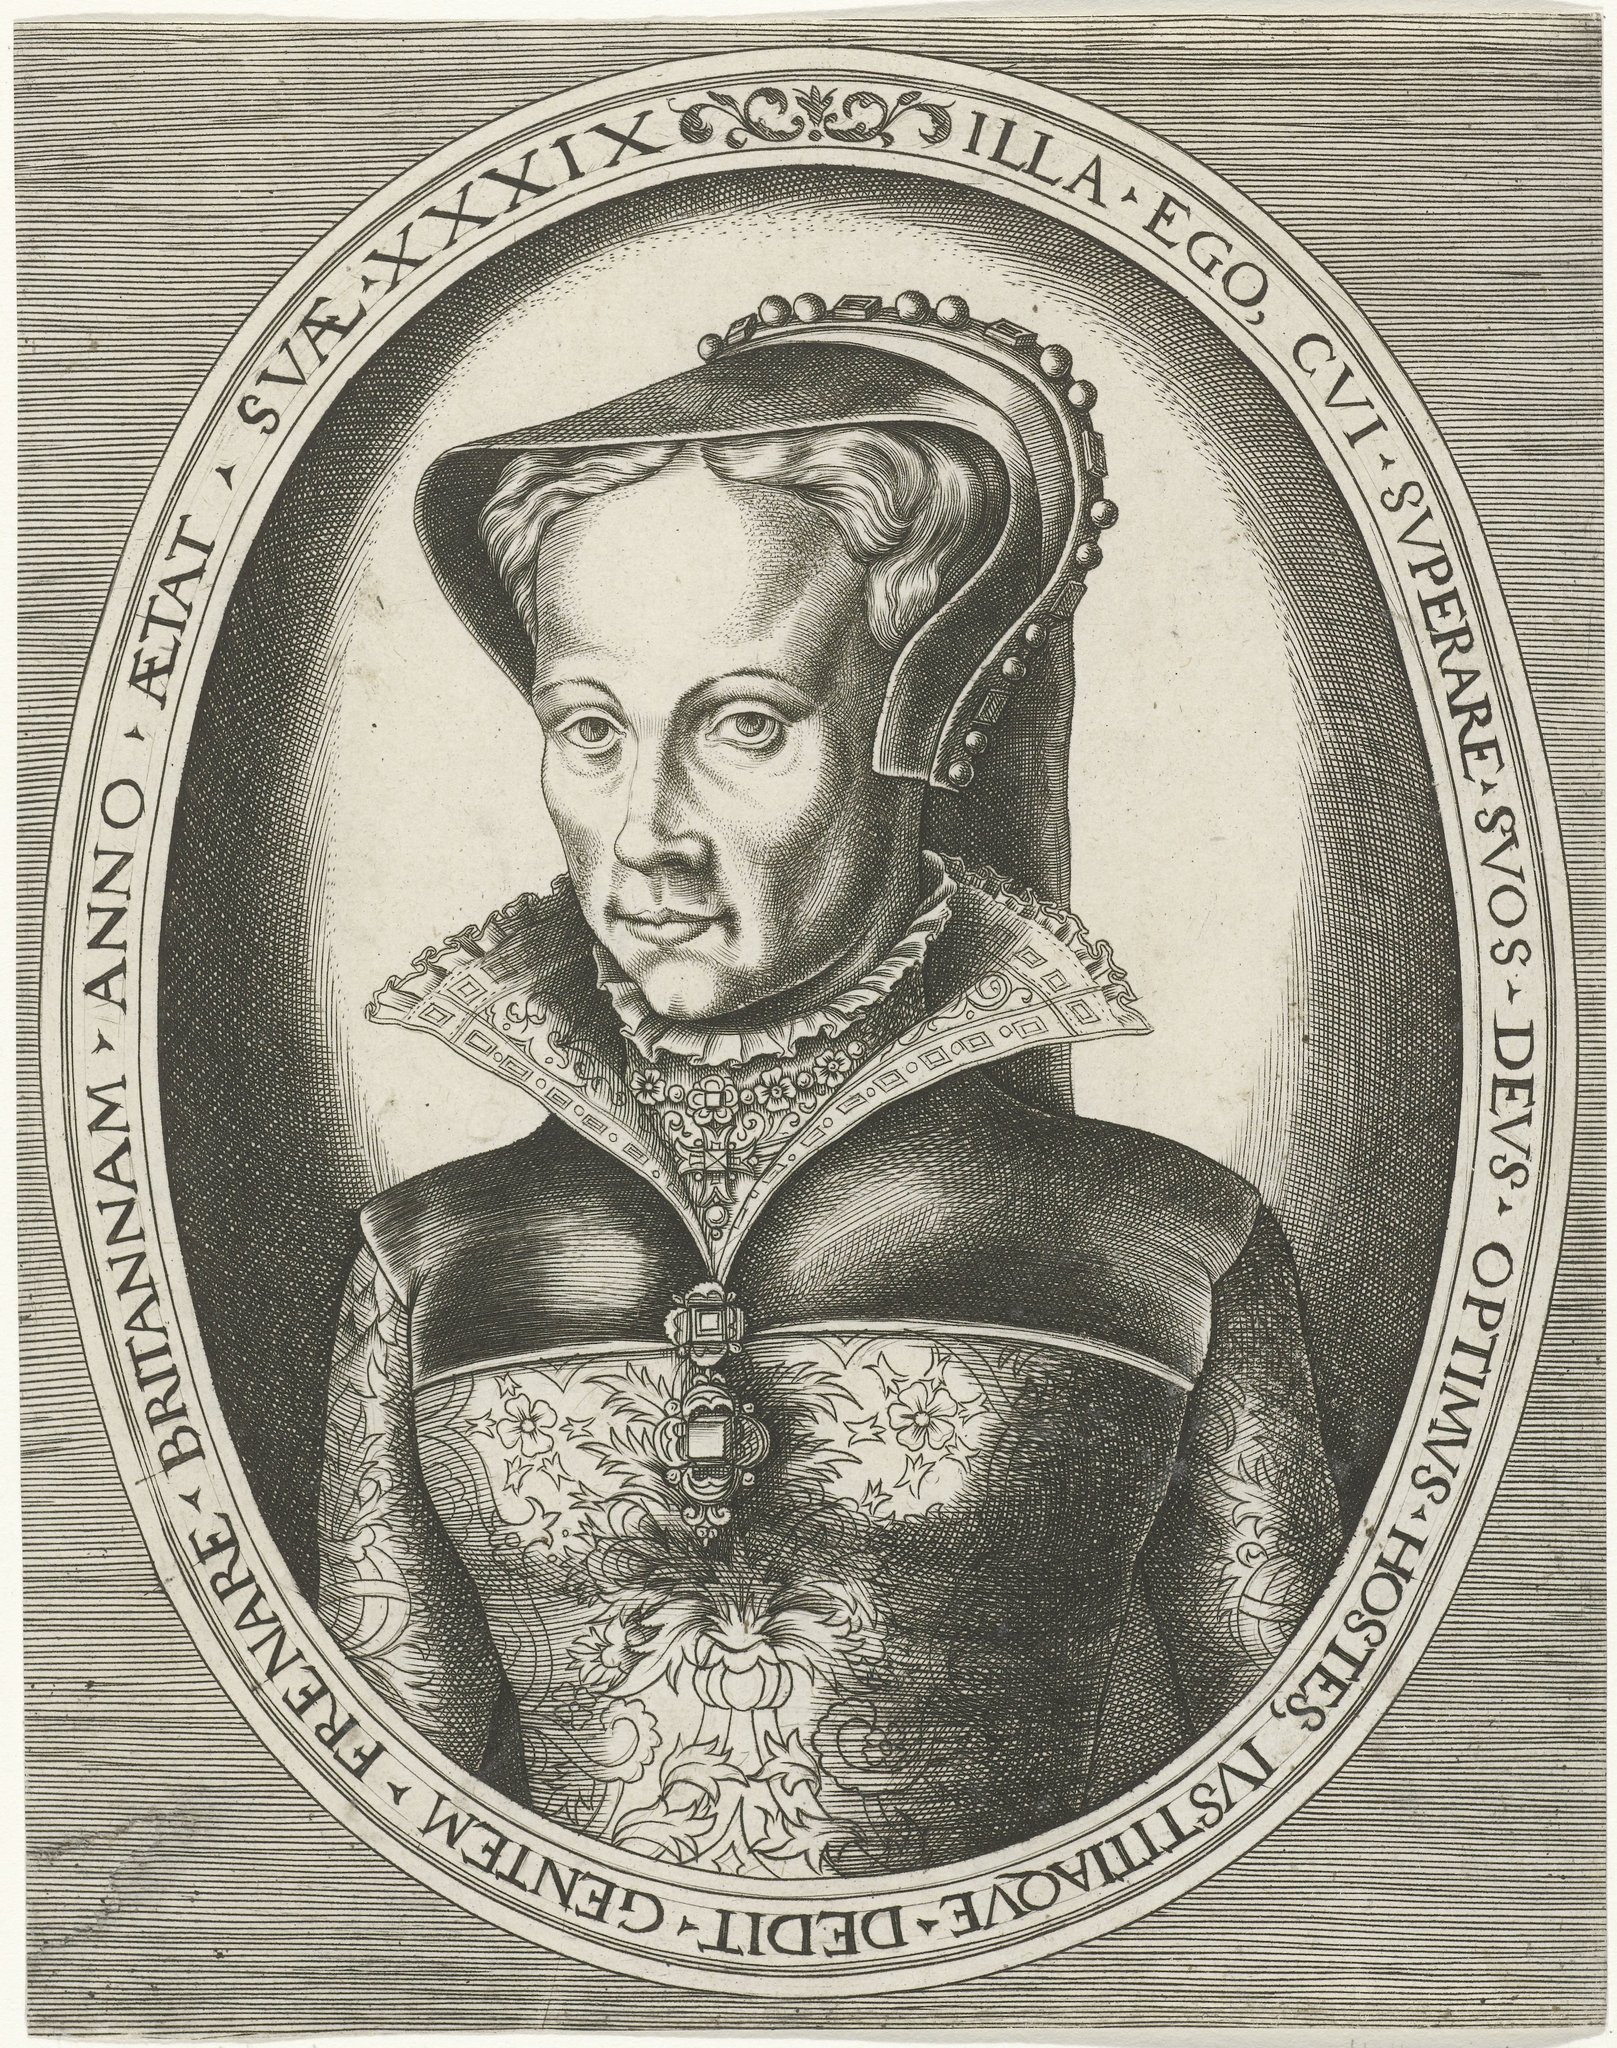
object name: print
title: Portret van Mary I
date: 1546-1562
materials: paper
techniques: engraving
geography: antwerp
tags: london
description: Buste van Mary I, koningin van Engeland, naar links in een ovale lijst met randschrift in het Latijn.